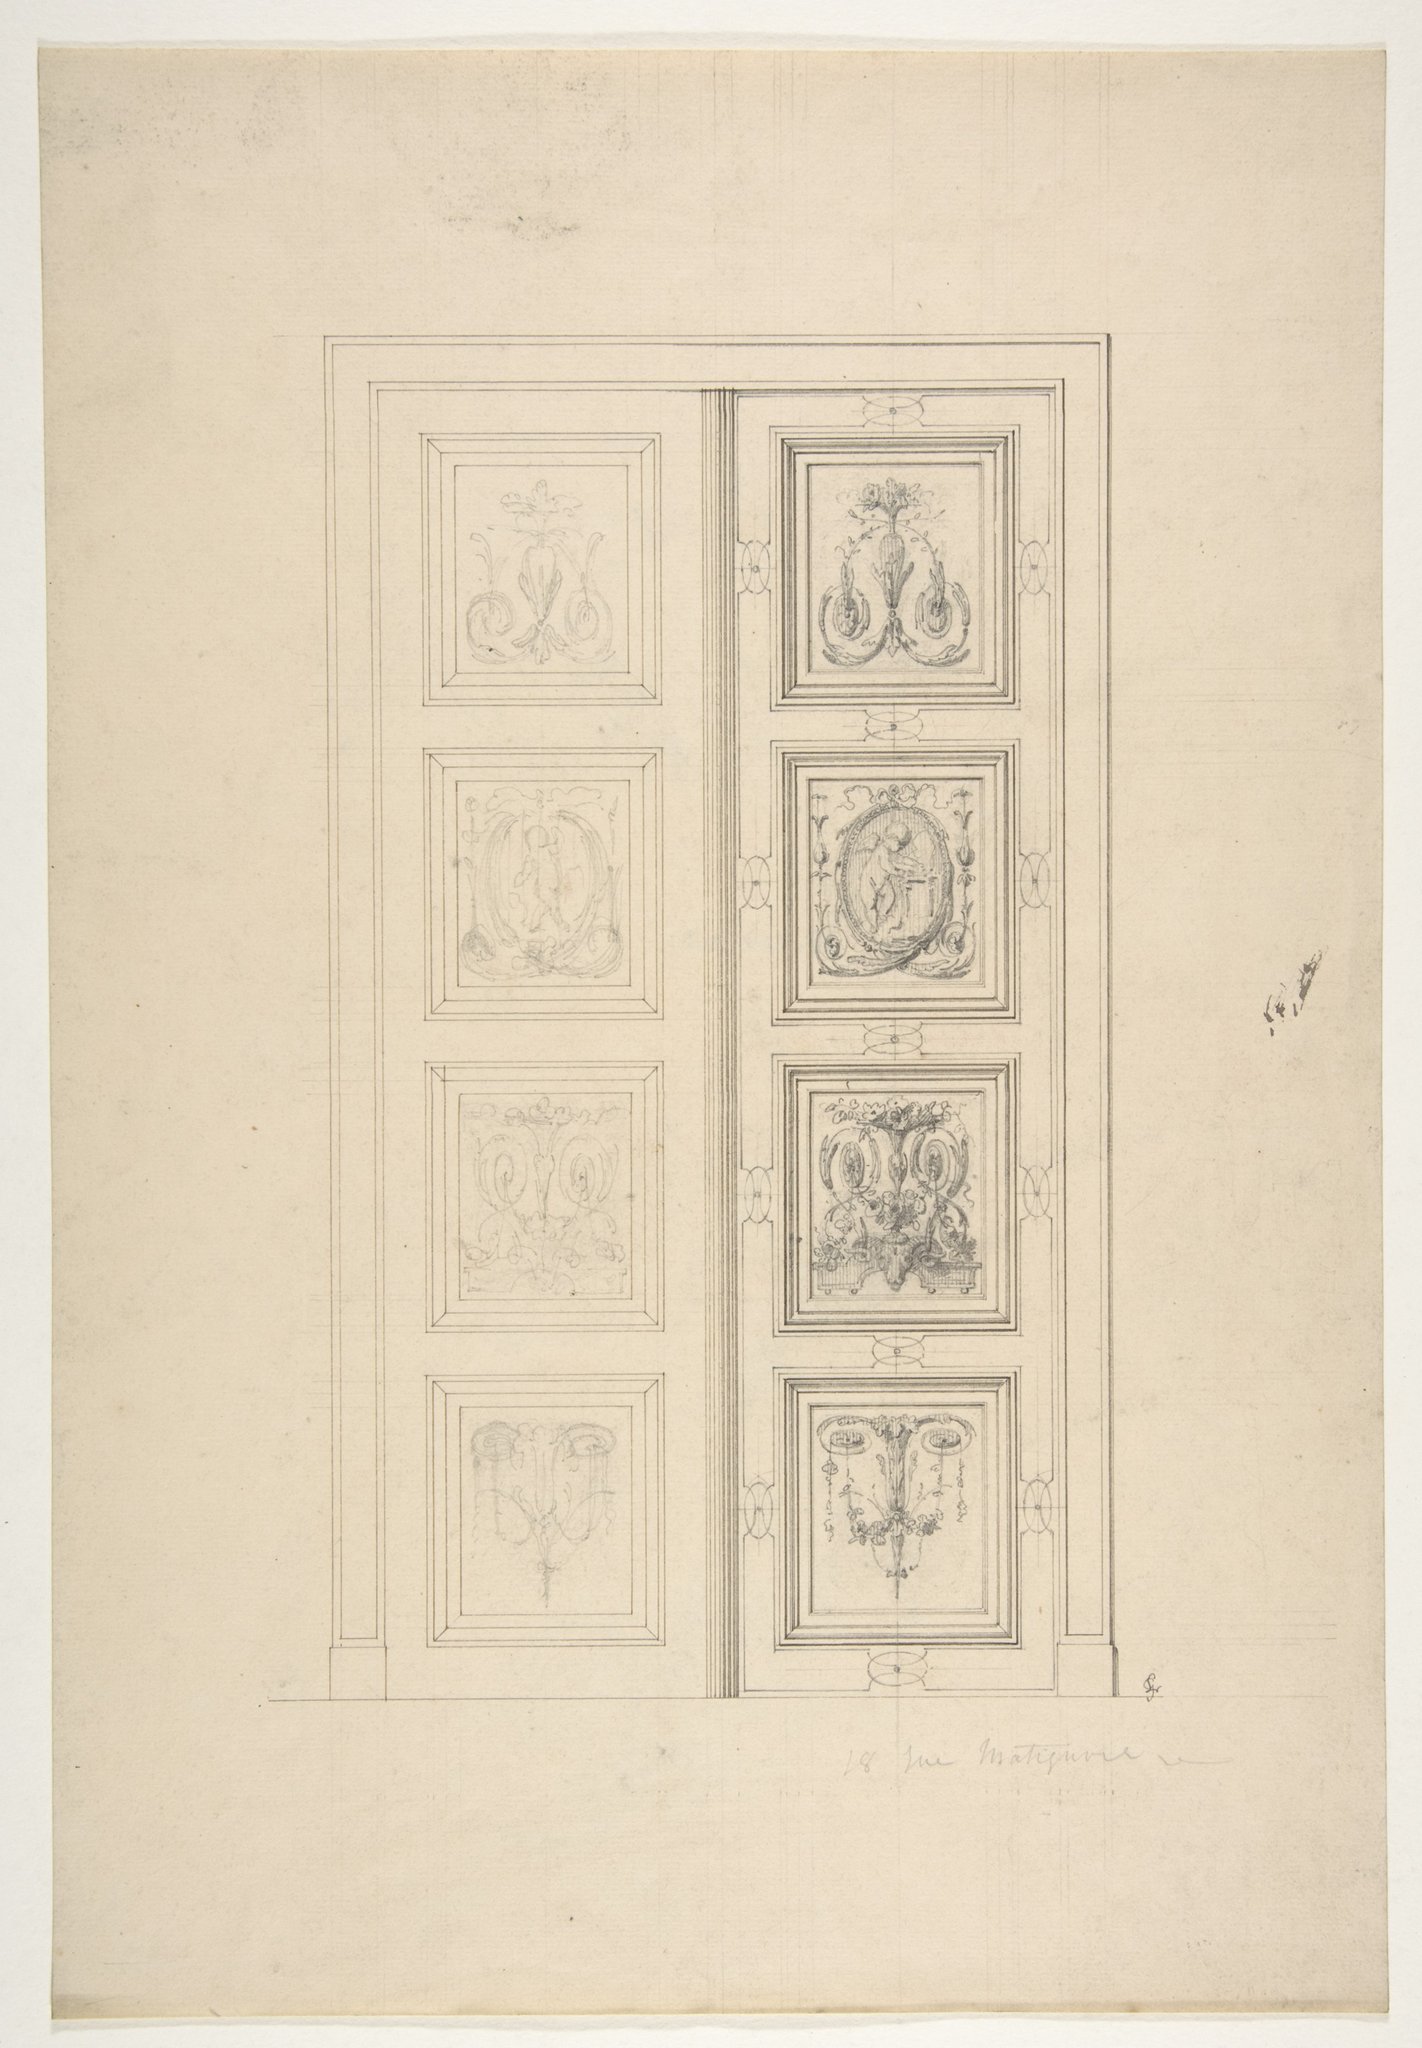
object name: drawing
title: Design for double doors in a house at 18 rue Matignon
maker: jules-edmond-charles lachaise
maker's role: artist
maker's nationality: french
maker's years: 1897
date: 1851-1900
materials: graphite, ink, paper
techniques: pen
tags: doors